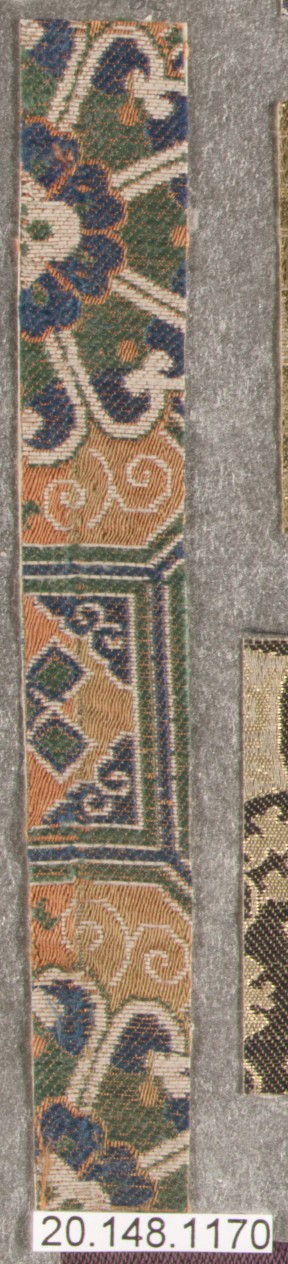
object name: piece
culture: china or japan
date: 1801-1900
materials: silk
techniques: compound weave